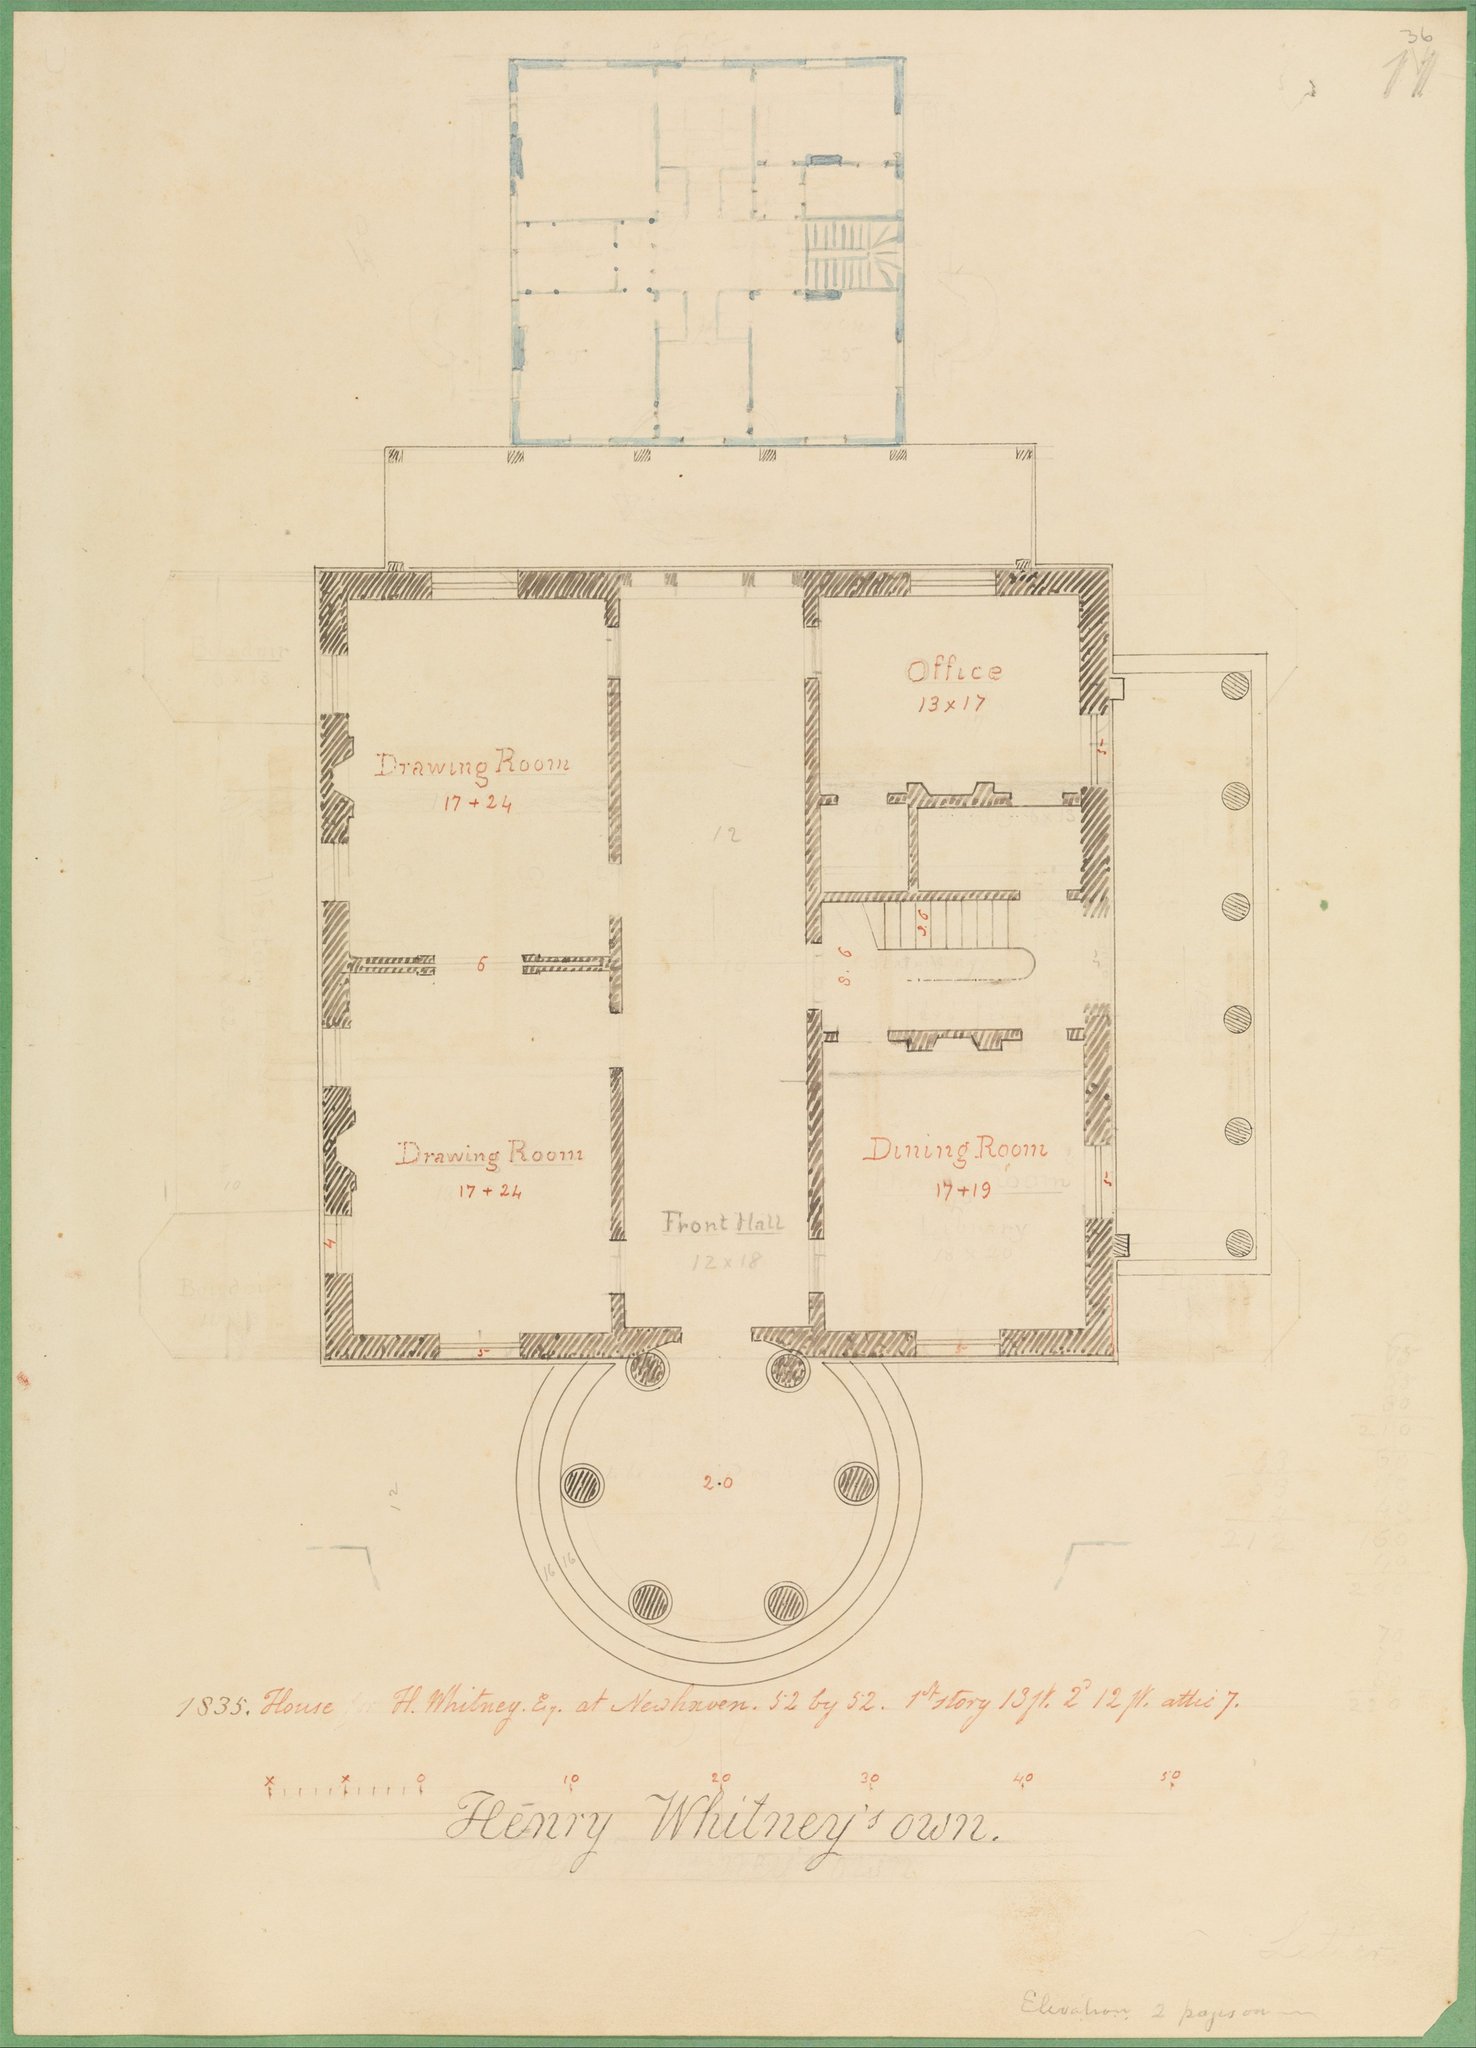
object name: drawing ornament architecture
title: House for Henry Whitney, New Haven, Connecticut (client's plan)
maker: alexander jackson davis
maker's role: artist and architect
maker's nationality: american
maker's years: 1803-1892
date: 1835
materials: graphite, ink, watercolor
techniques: pen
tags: architecture,houses